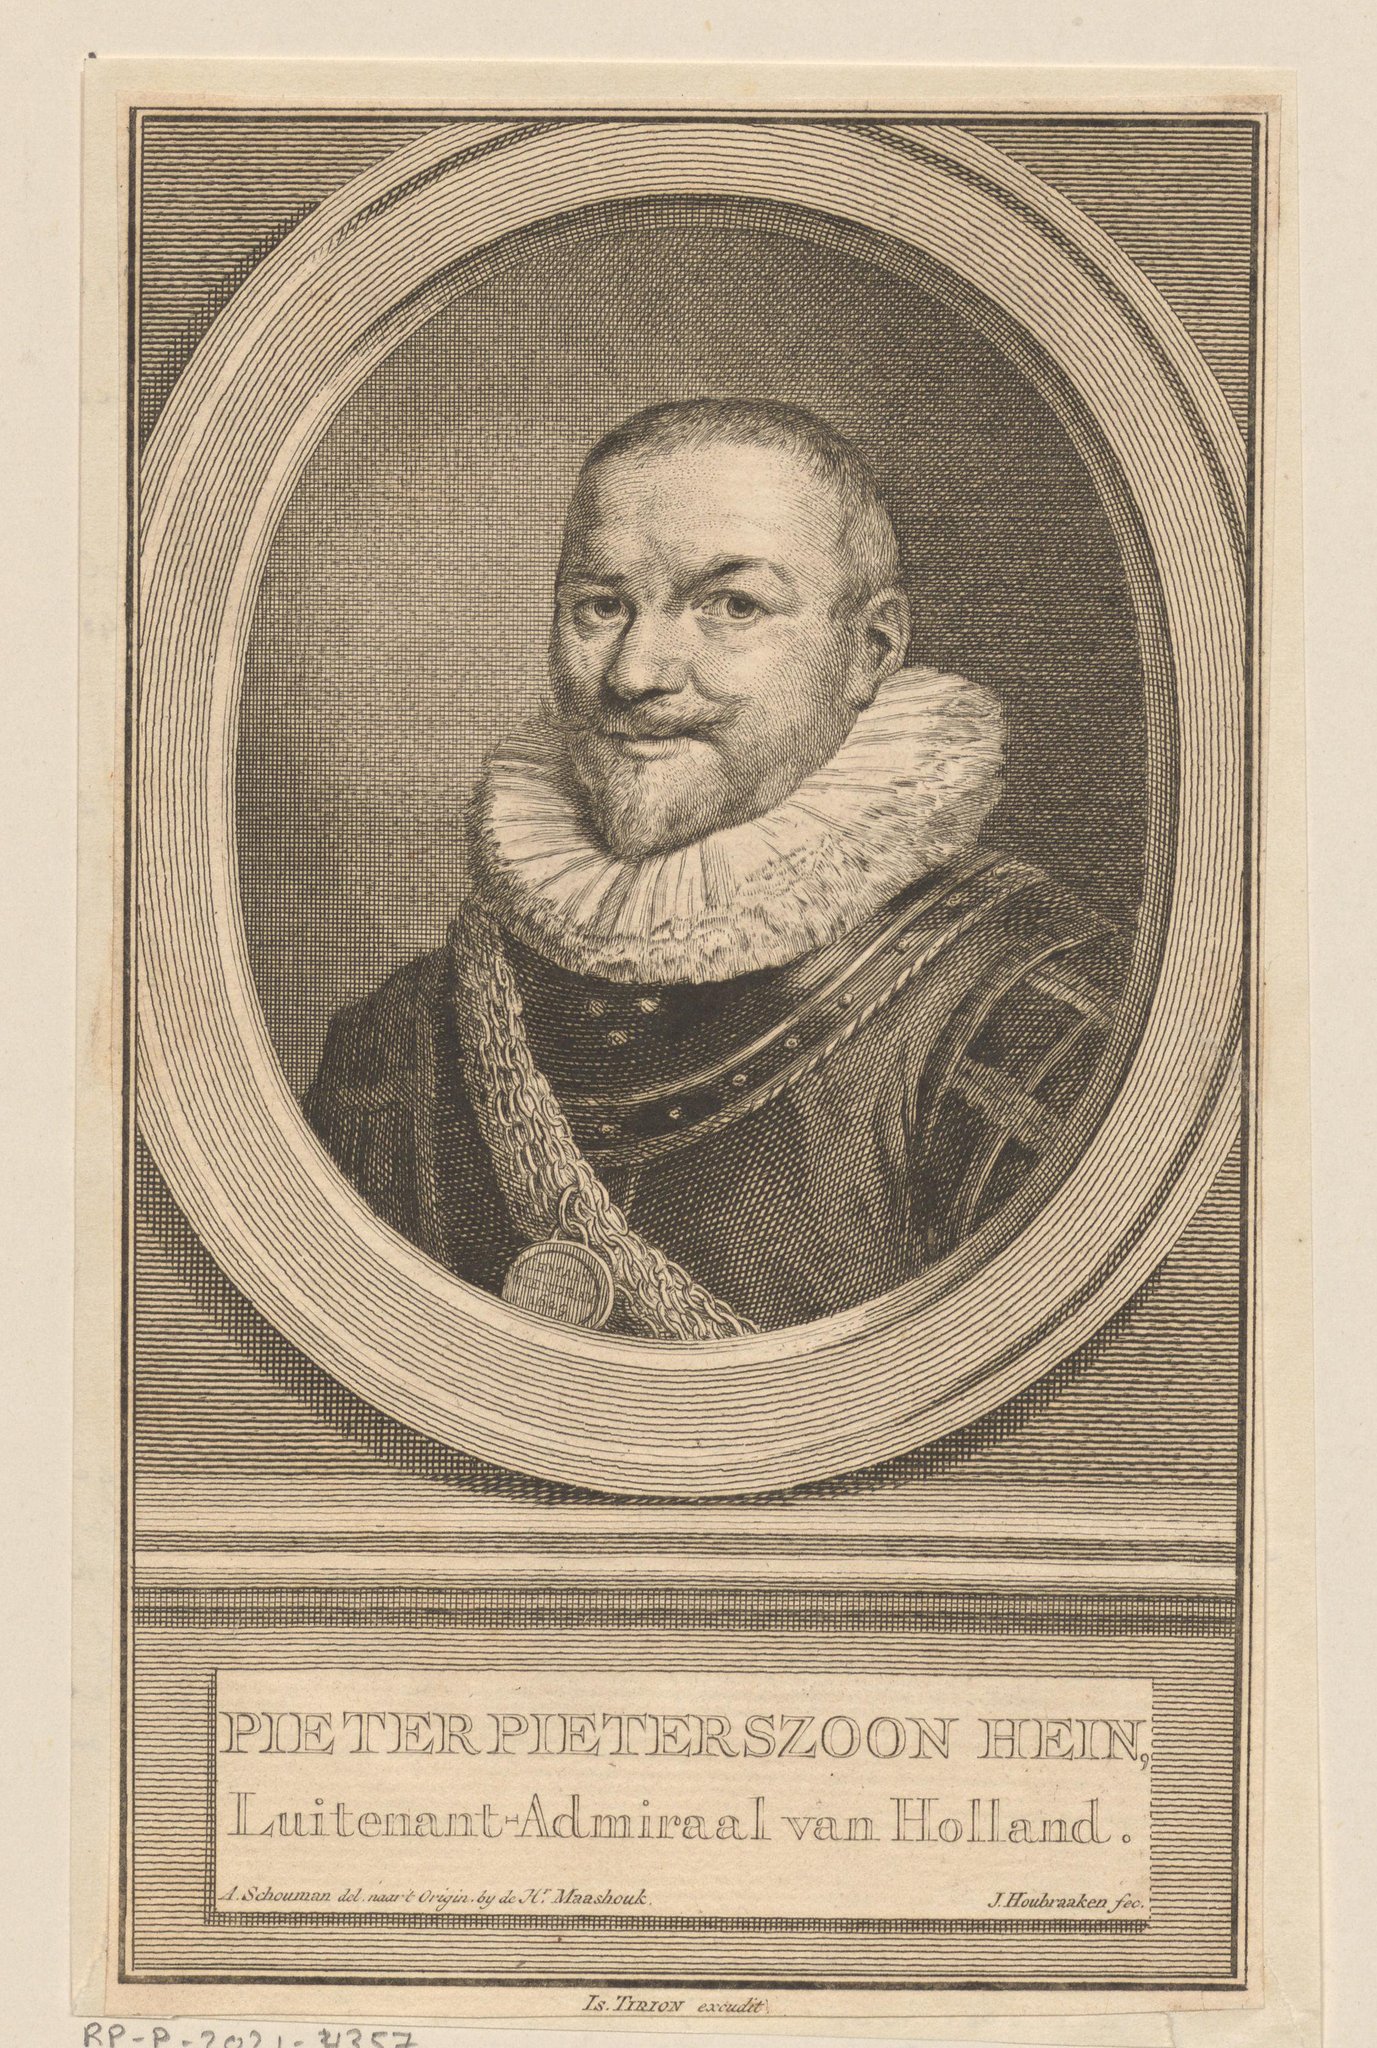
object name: book illustration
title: Pieter Pieterszoon Hein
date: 1749-1759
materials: paper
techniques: engraving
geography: amsterdam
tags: delfshaven, historical persons, commander-in-chief, admiral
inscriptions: inscription: ‘Zie over hem:/ J. Wagenaar, Vaderl. Hist (...)’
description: Prent gebruikt in: Wagenaar, Jan. Vaderlandsche historie, vervattende de geschiedenissen der nu Vereenigde Nederlanden (...). 21 dln. Amsterdam: Isaak Tirion, 1749-1759, dl. 11. Prent ook gebruikt in latere edities van dit werk.